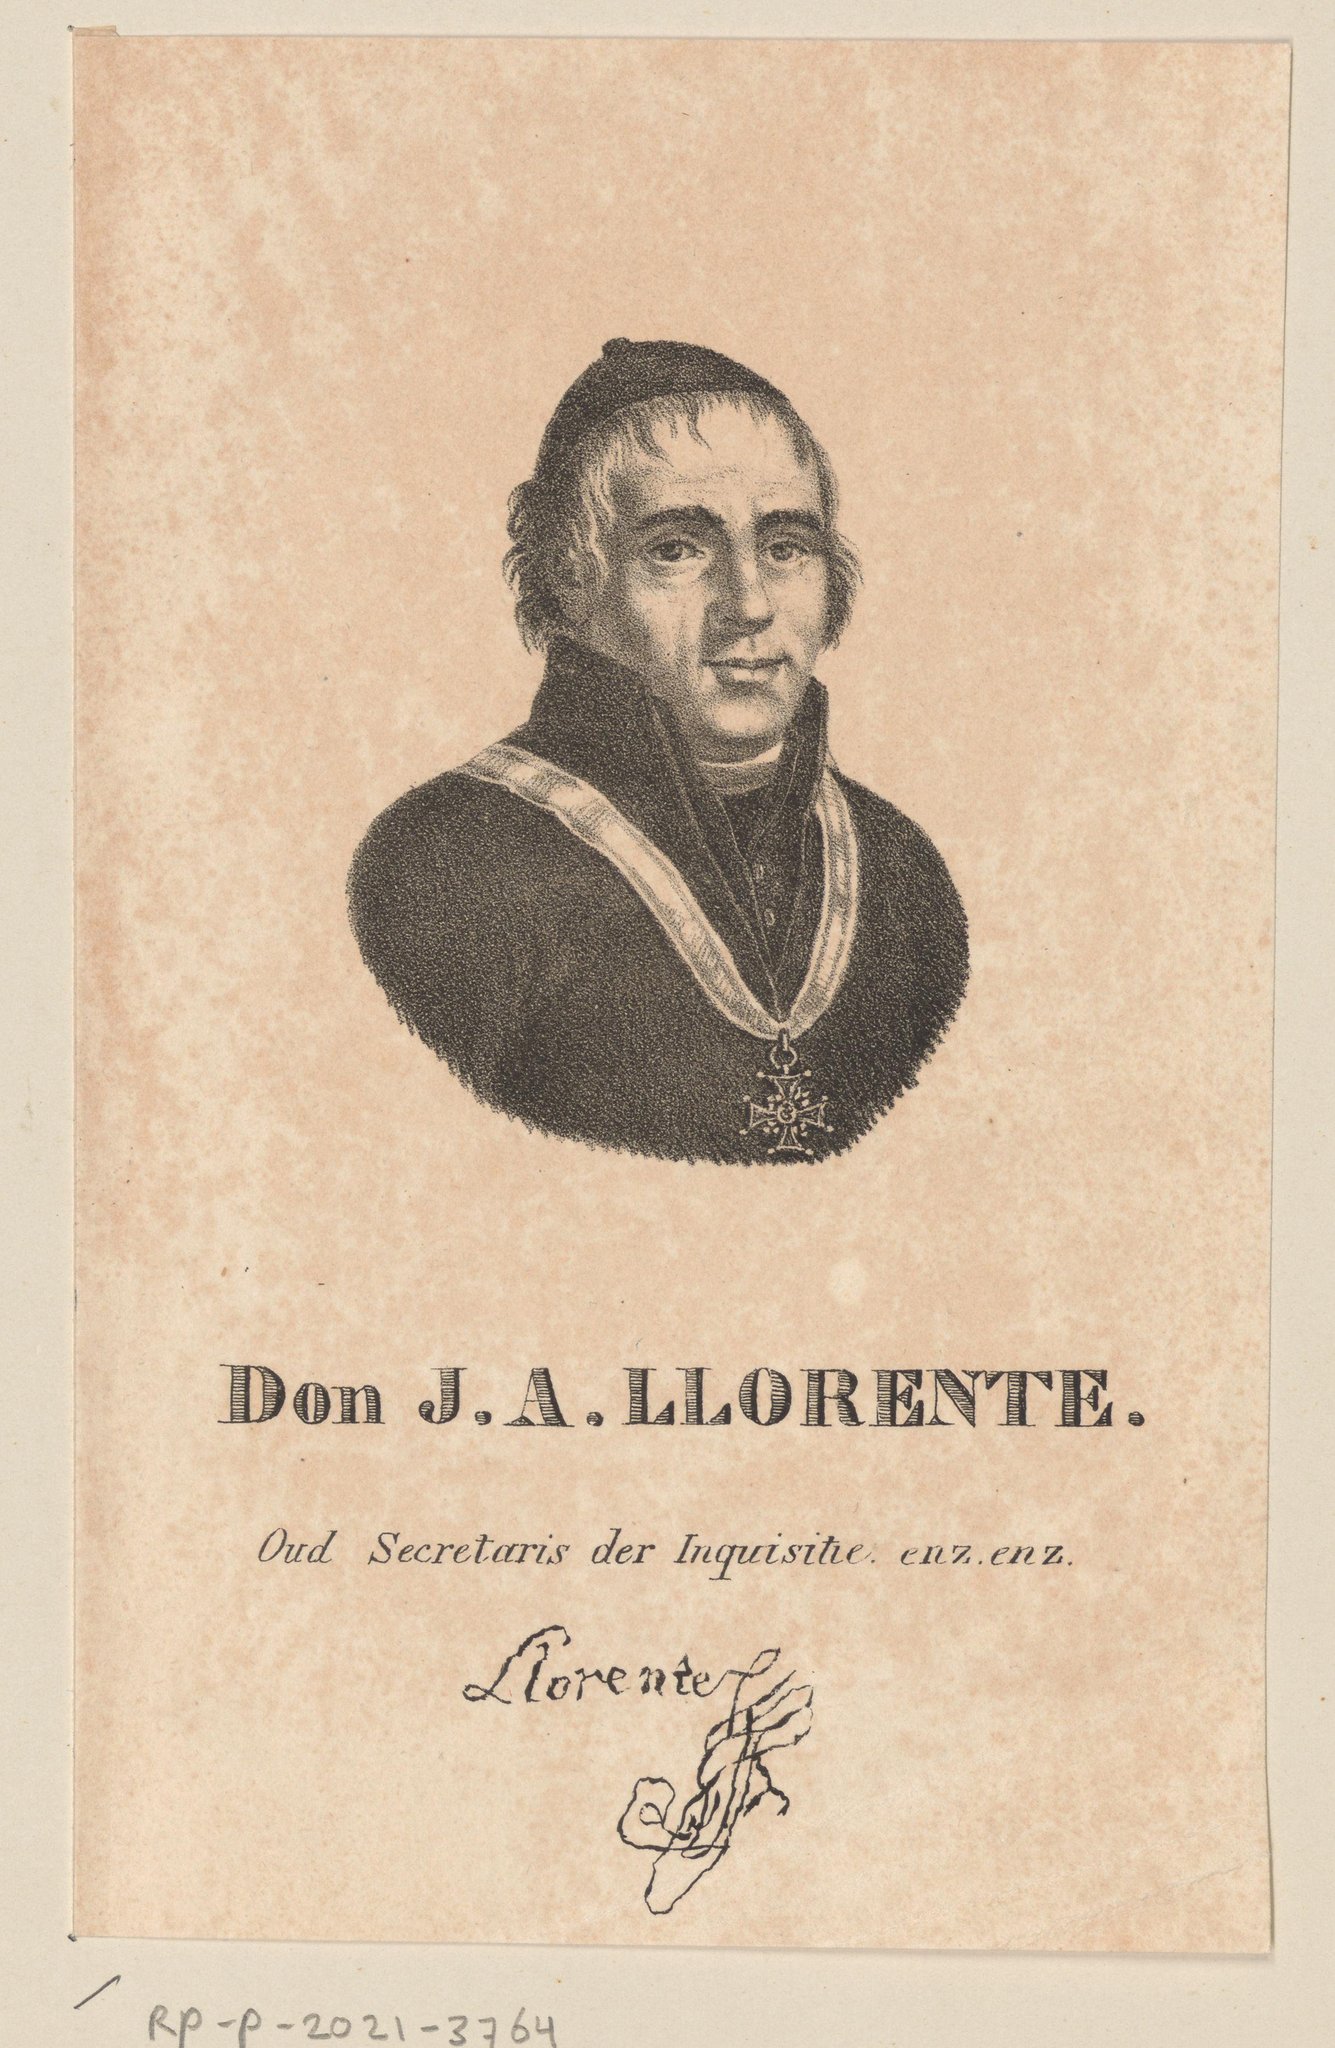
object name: print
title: Portret van Juan Antonio Llorente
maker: Anonymous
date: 1825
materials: paper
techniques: lithograph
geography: netherlands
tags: history and archaeology (+ portrait of scholar, scientist), historical persons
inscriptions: date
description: Prent waarschijnlijk uit: Llorente, Juan Antonio. Verkorte Geschiedenis der Spaansche Inquisitie (...). Franeker: G. Ypma, 1825.